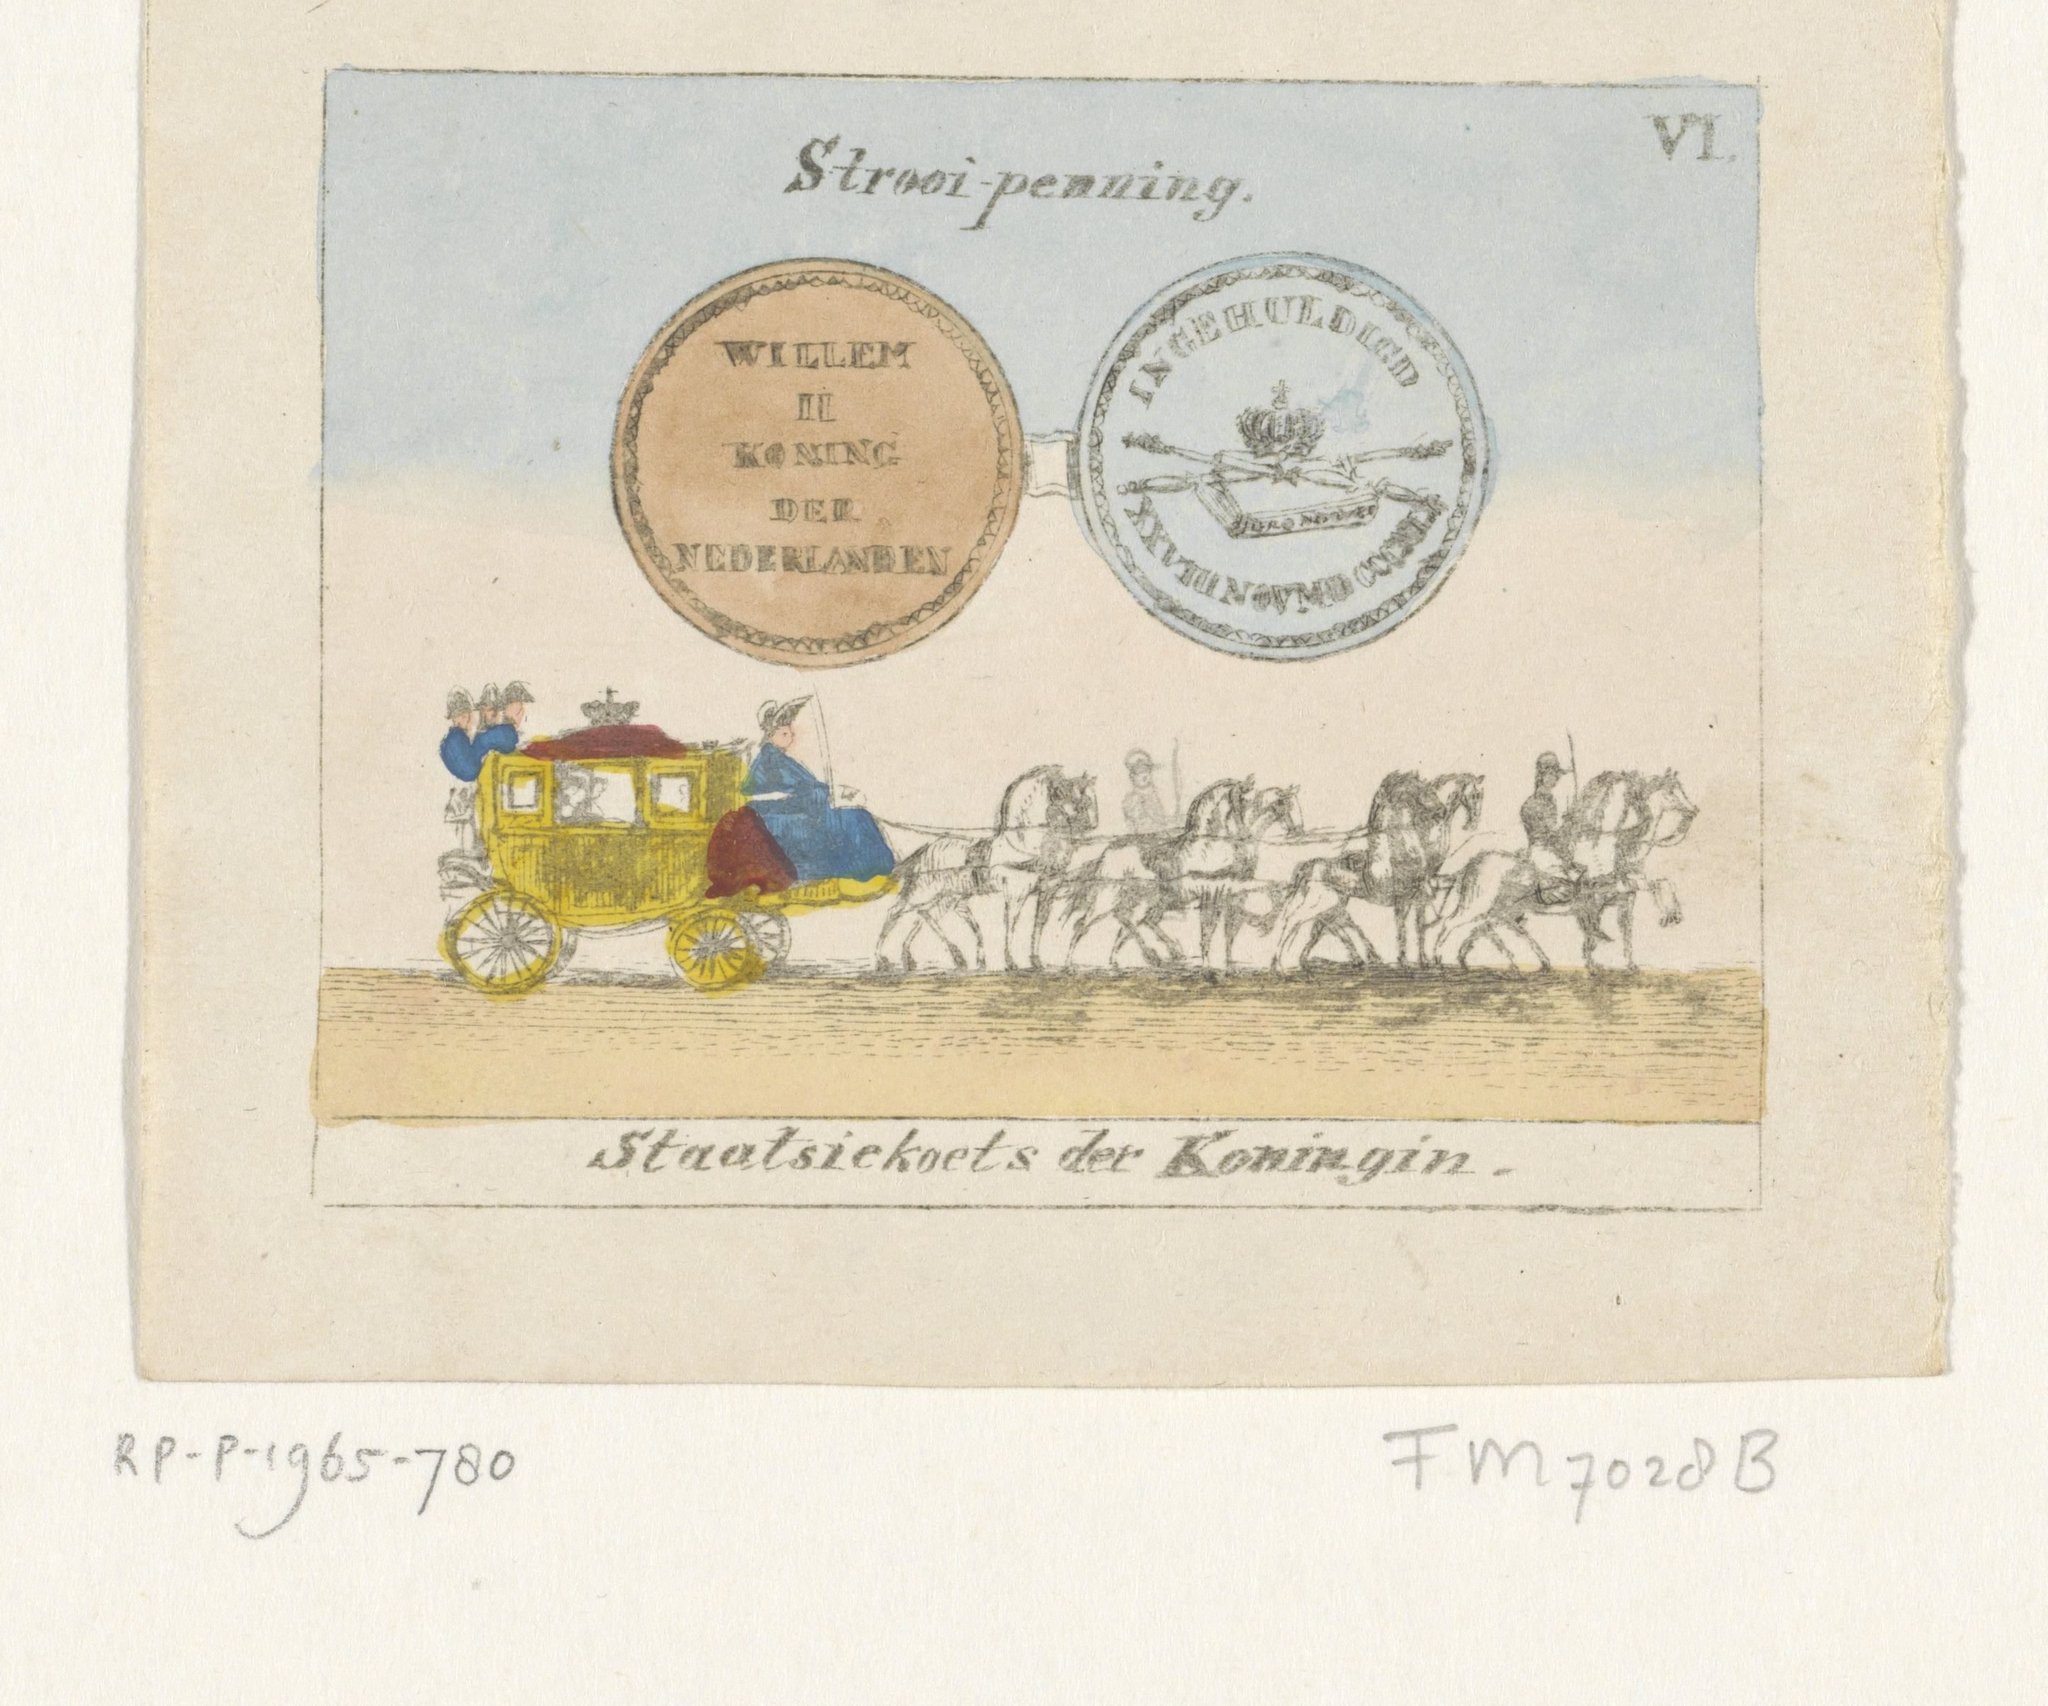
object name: print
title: Staatsiekoets der Koningin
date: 1840-1841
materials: paper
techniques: hand coloring, lithograph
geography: amsterdam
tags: the hague, william ii of the netherlands, scattering of money (~ triumphal entry, etc.), other forms of installation, coin, four-wheeled vehicle drawn by more than three animals, amsterdam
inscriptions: collector's mark: Lugt 2228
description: Staatsiekoets der Koningin en de strooipenning. Onderdeel van mapje met een serie van twaalf prentjes van de intocht van Willem II, de erepoorten opgericht in de stad en de inhuldiging op 28 november 1840 in de Nieuwe Kerk te Amsterdam.